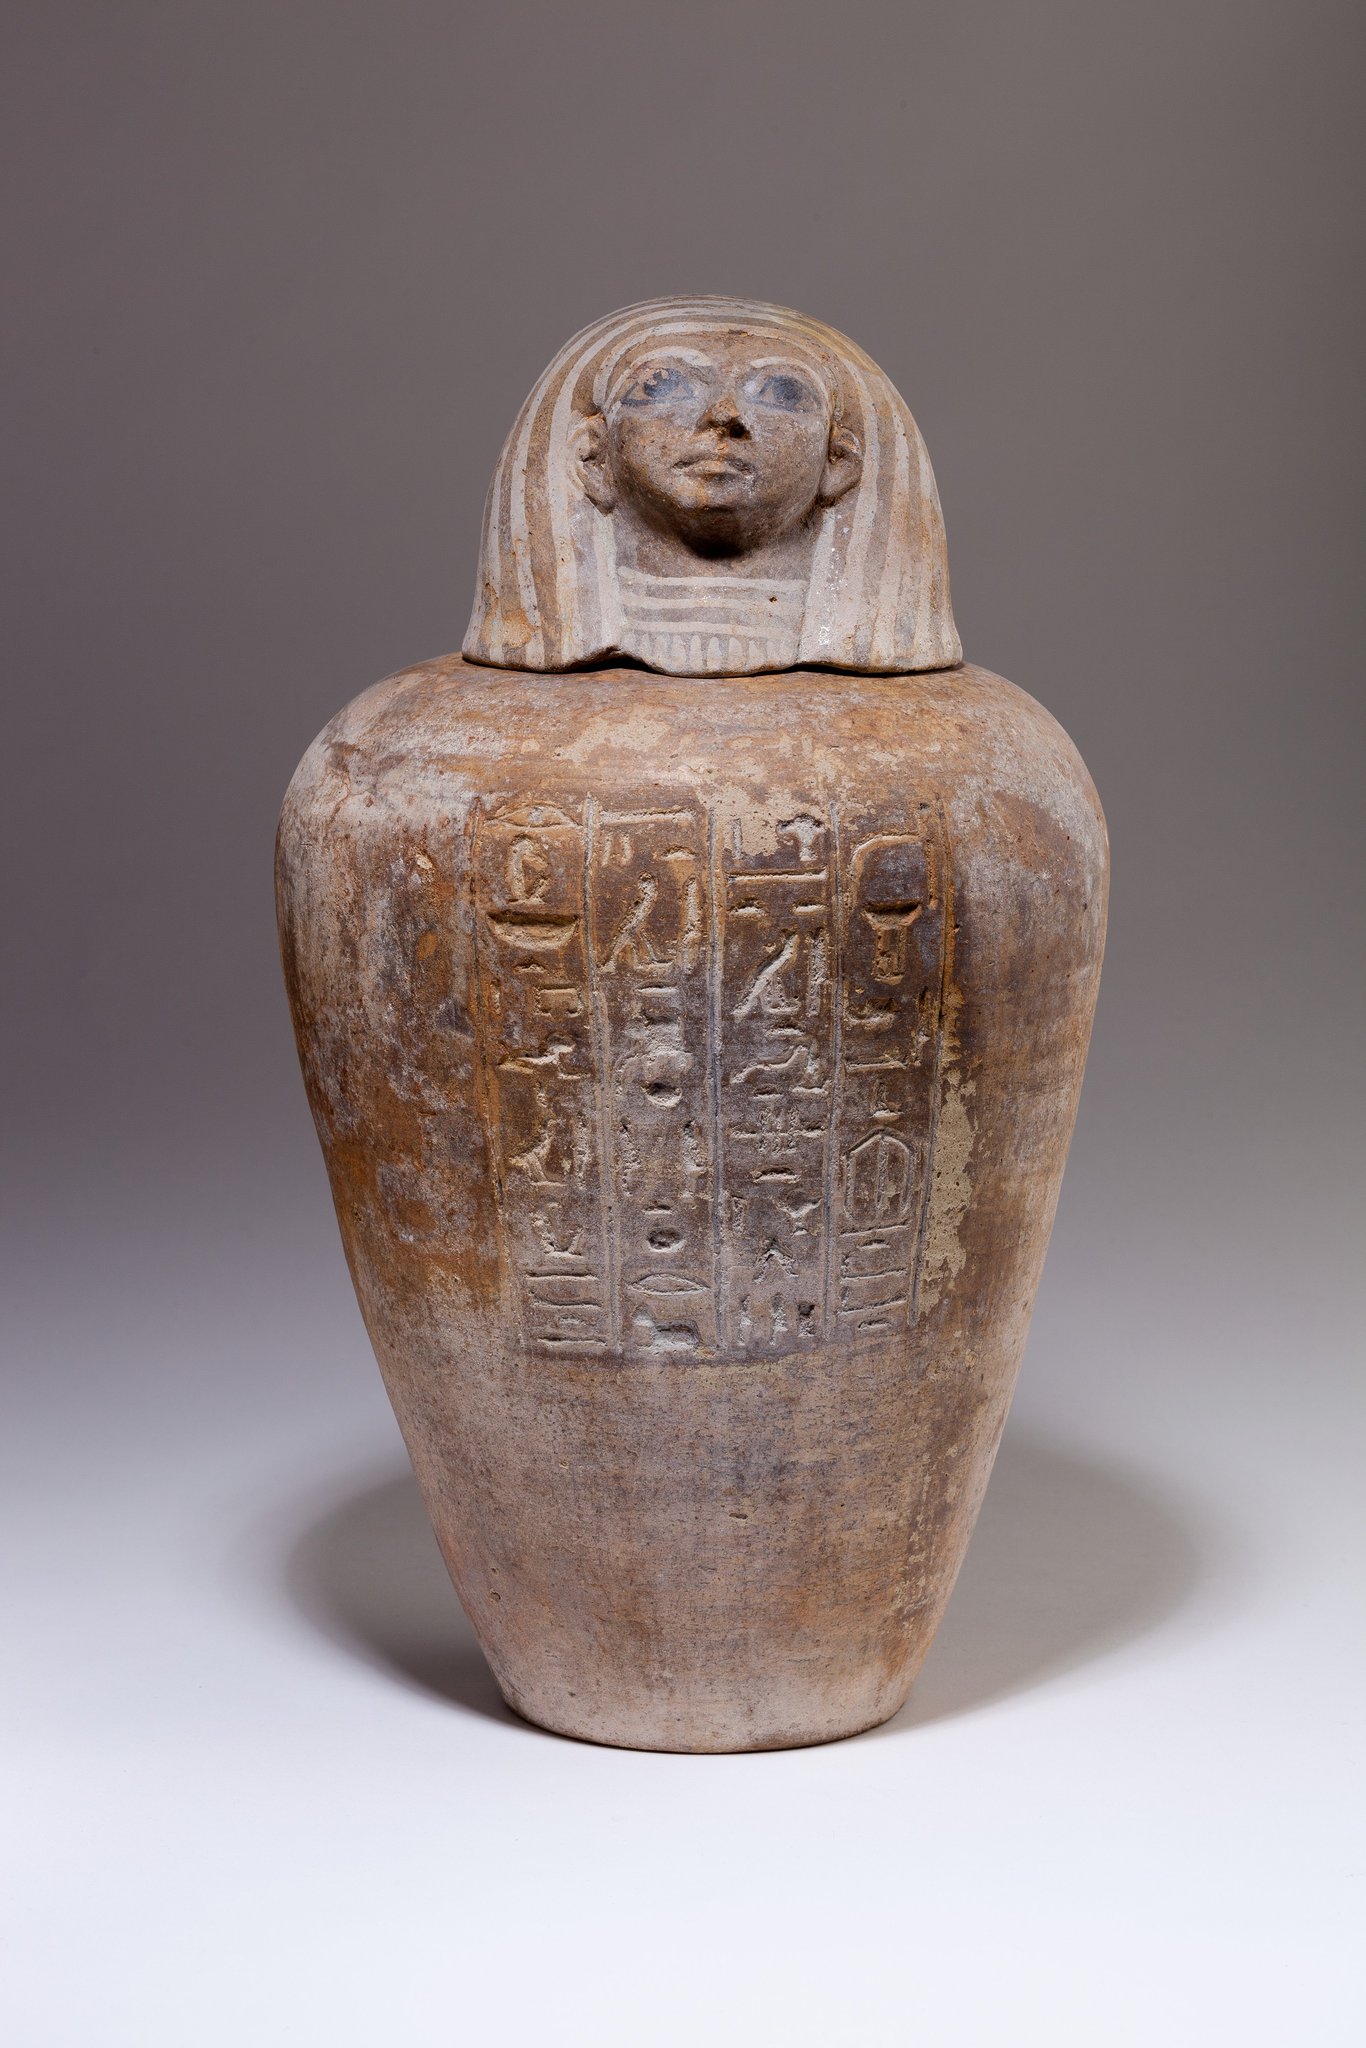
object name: canopic jar, ruiu, human head, hapy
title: Canopic Jar of Ruiu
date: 1504-1447 BCE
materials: paint, pottery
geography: egypt